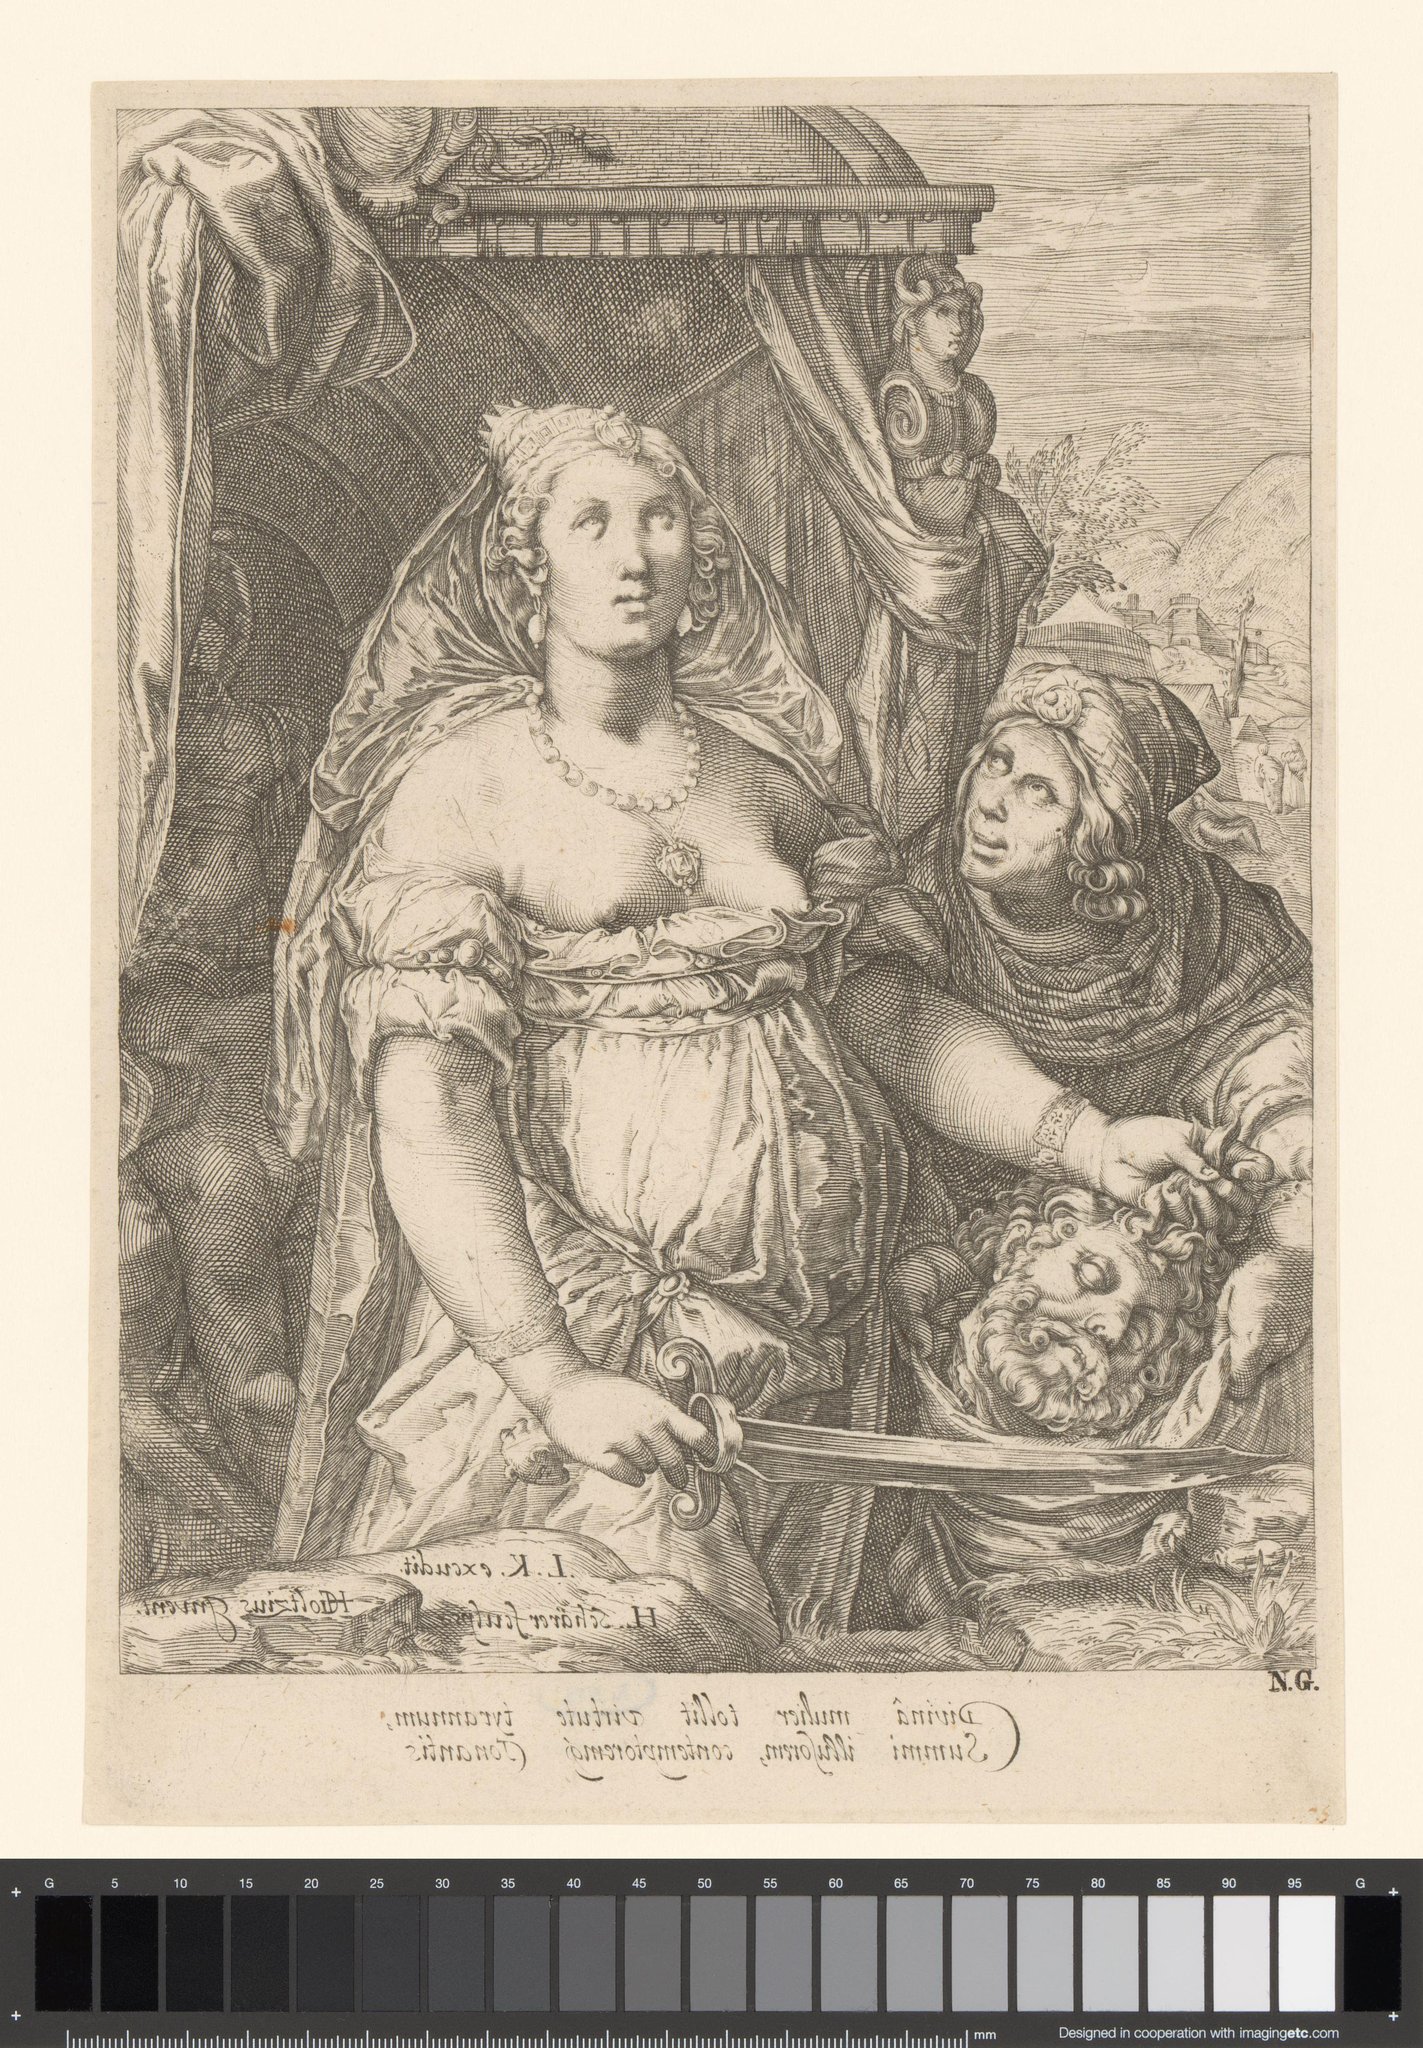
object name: print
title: Judit met het hoofd van Holofernes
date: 1610-1620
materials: paper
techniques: engraving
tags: judith and holofernes (judith 8-16)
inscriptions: collector's mark: Lugt 1967, collector's mark: Lugt 2228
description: Tegendruk van een kopie in de tegenovergestelde richting naar het origineel van Goltzius.